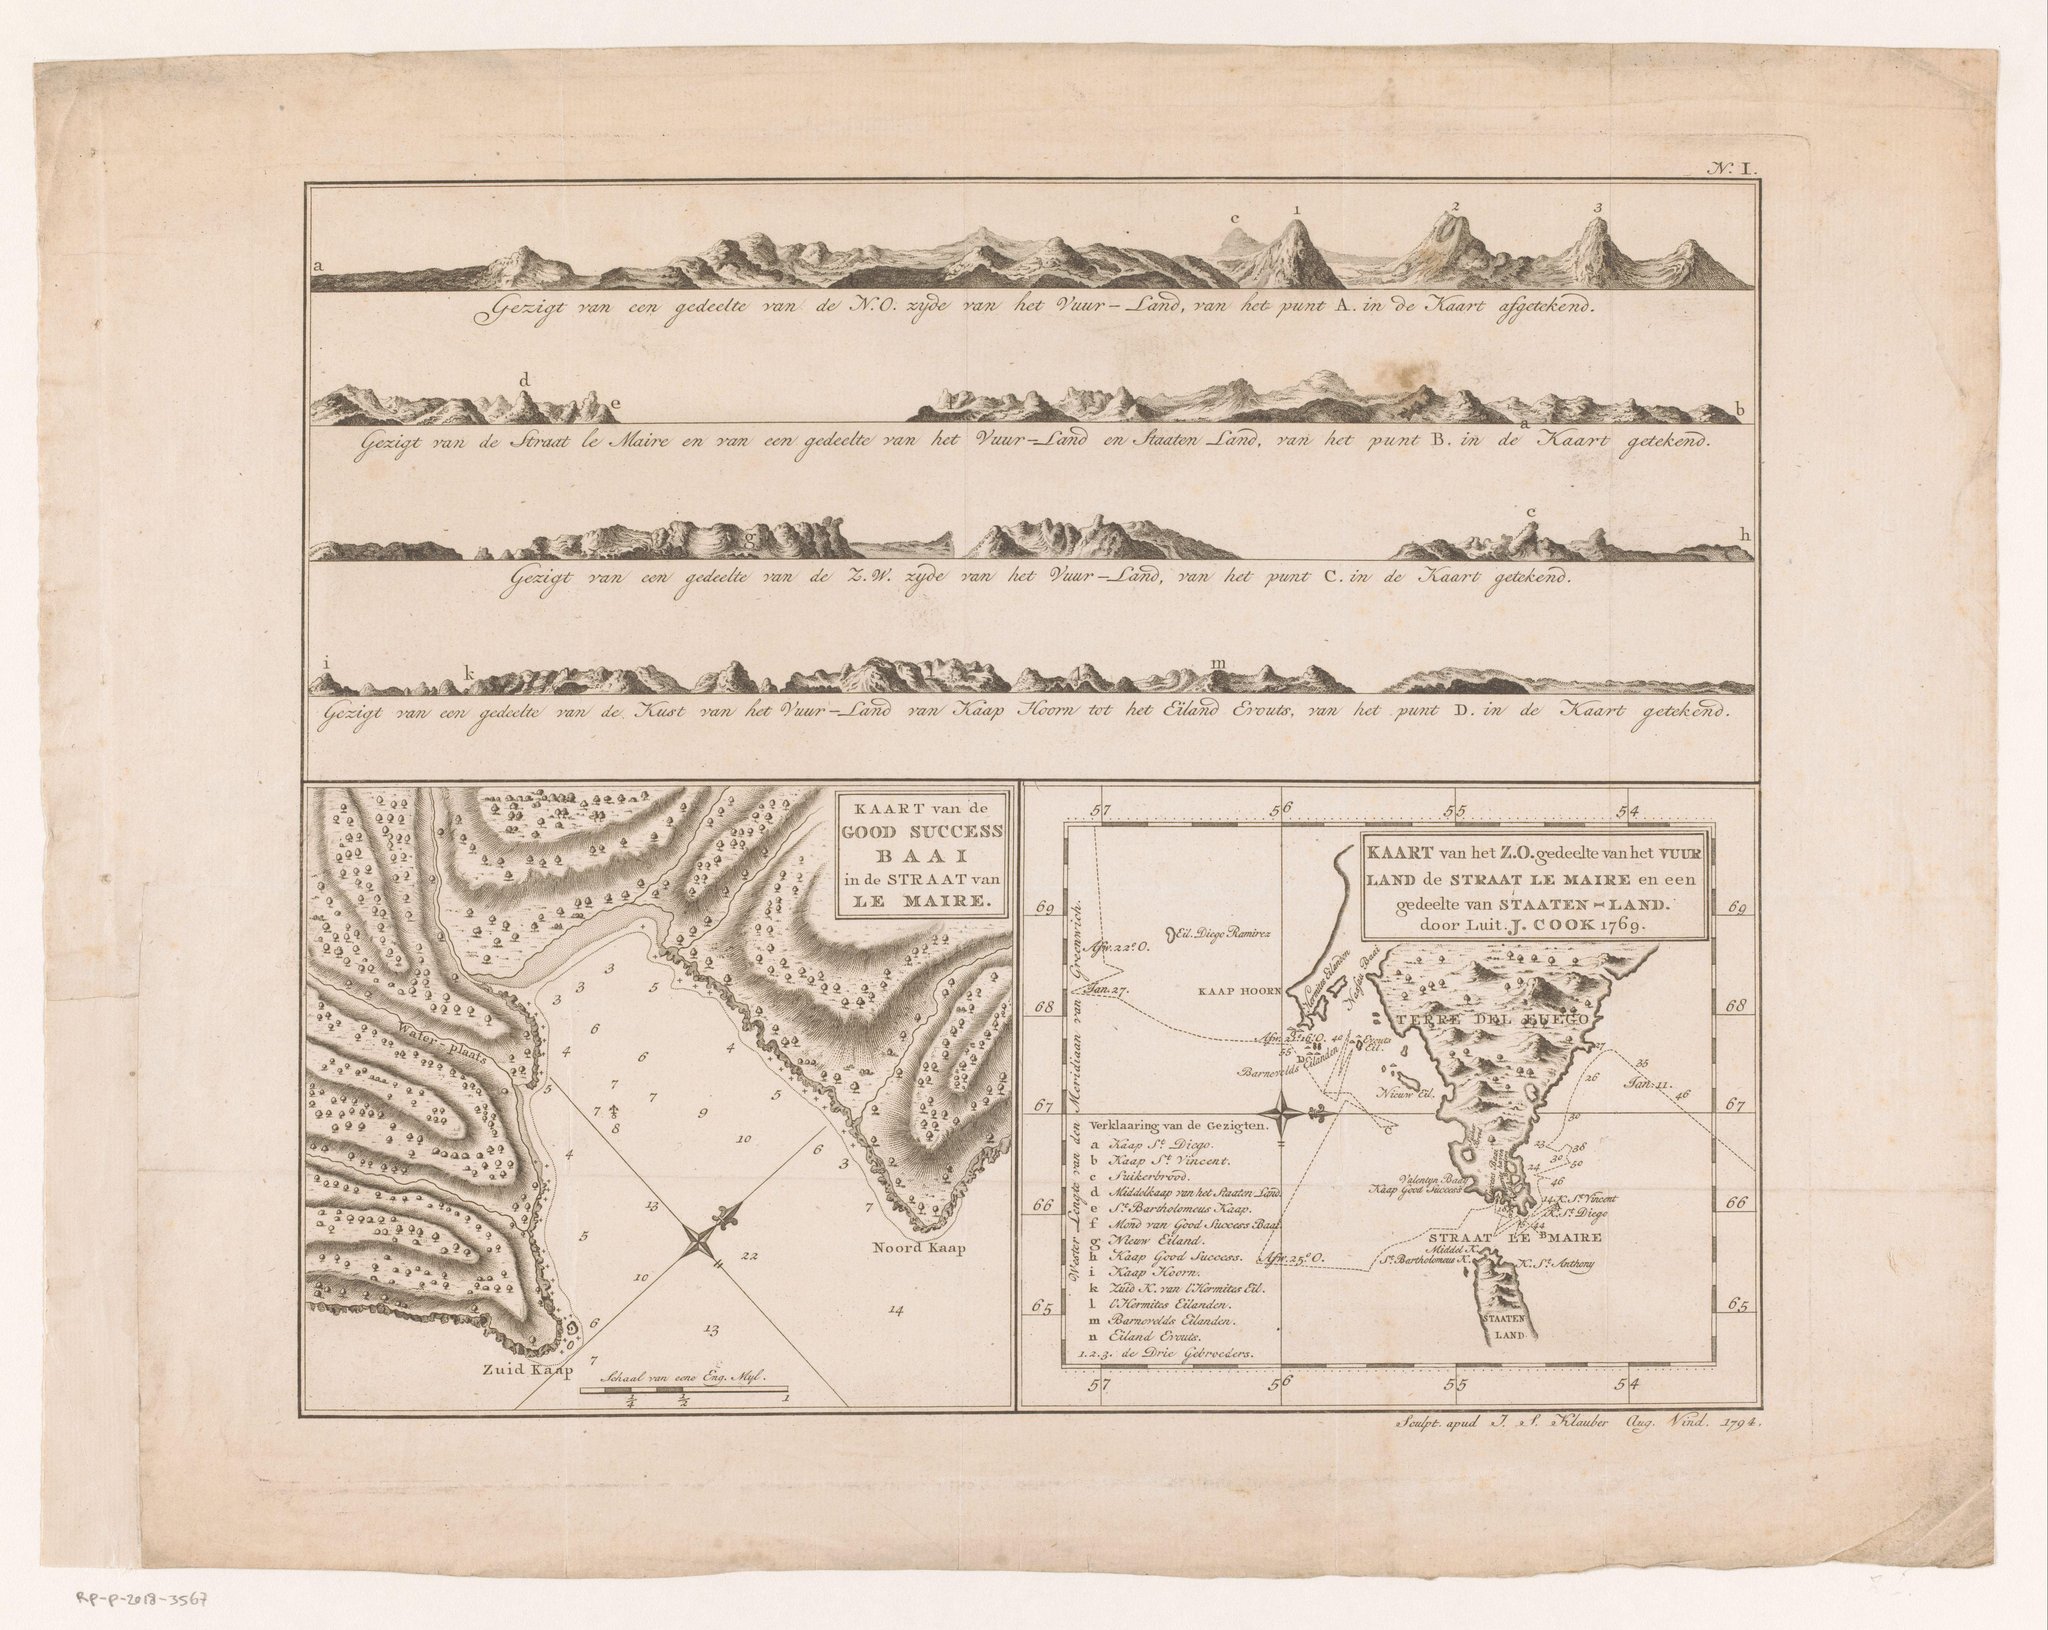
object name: map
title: Kaarten van Vuurland, Le Maire en Staaten-Land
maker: joseph sebastian klauber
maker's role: print maker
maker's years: 1710-1768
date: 1794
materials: paper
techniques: etching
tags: maps, atlases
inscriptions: collector's mark: Lugt 2228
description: Boven kustgezichten van het gebied bij Vuurland. Linksonder een kaart van de Good Success baai en rechtsonder een kaart van Vuurland, de Straat Le Maire en een gedeelte van Staaten-Land gemaakt door James Cook in 1769.